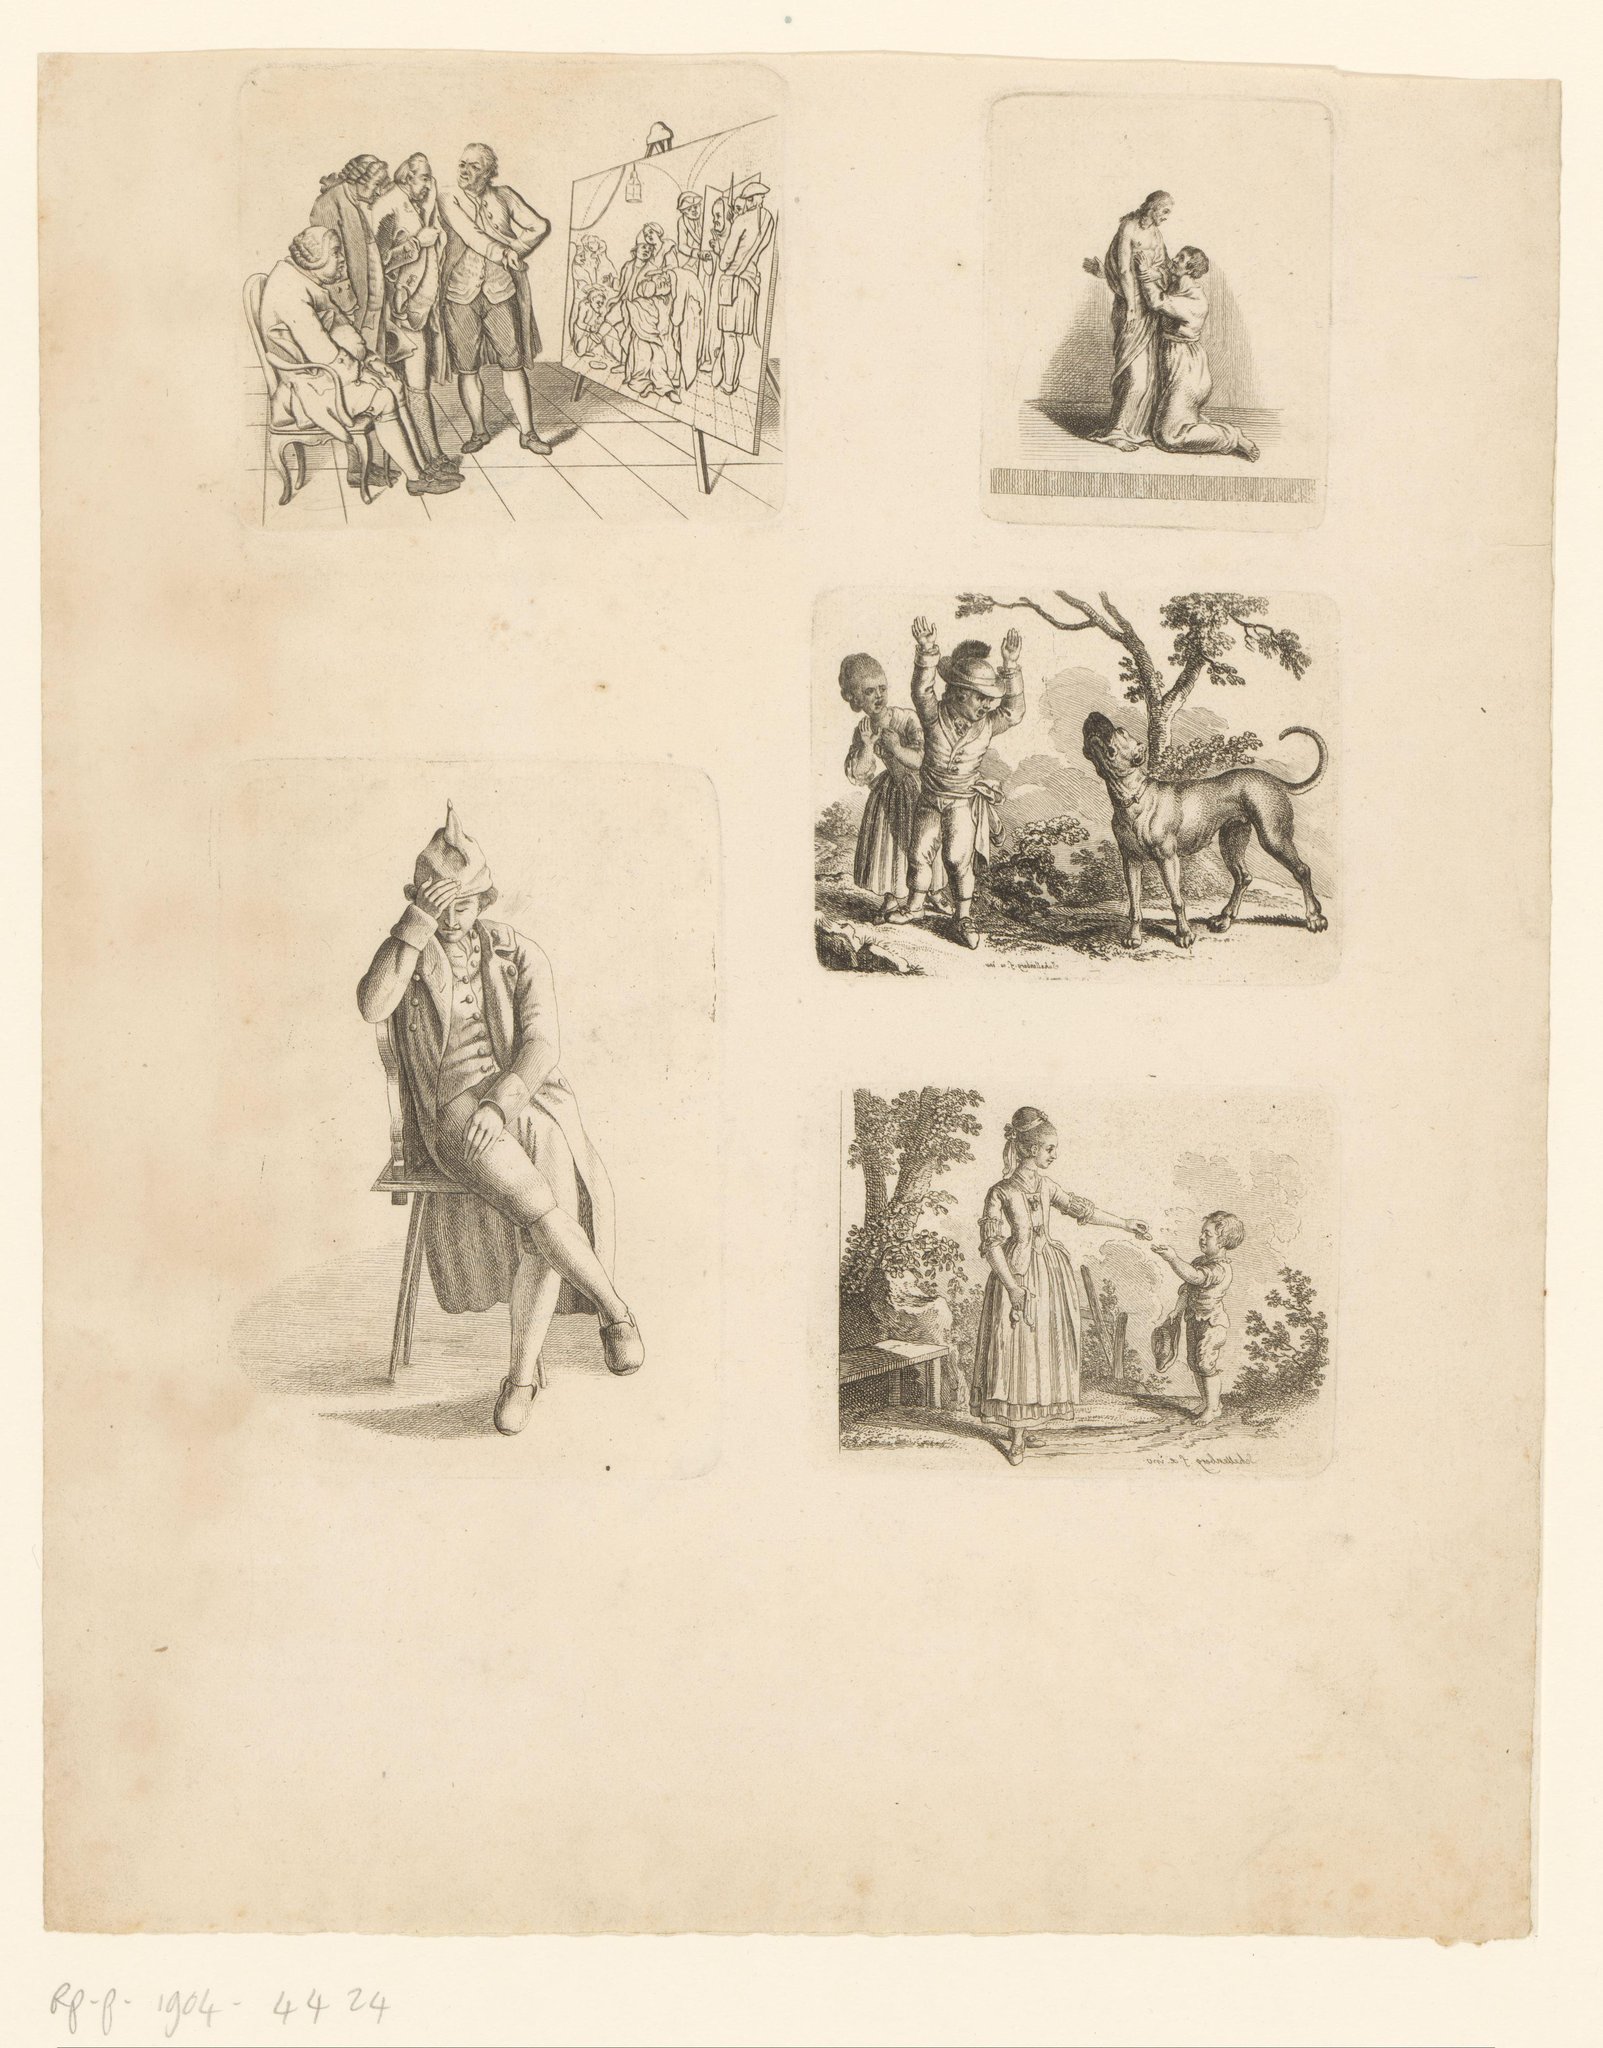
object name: print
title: Vijf voorstellingen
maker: johann rudolph schellenberg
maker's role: print maker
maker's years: 1740-1806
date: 1750-1806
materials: paper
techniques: etching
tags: human being, man in general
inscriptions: collector's mark: Lugt 2228